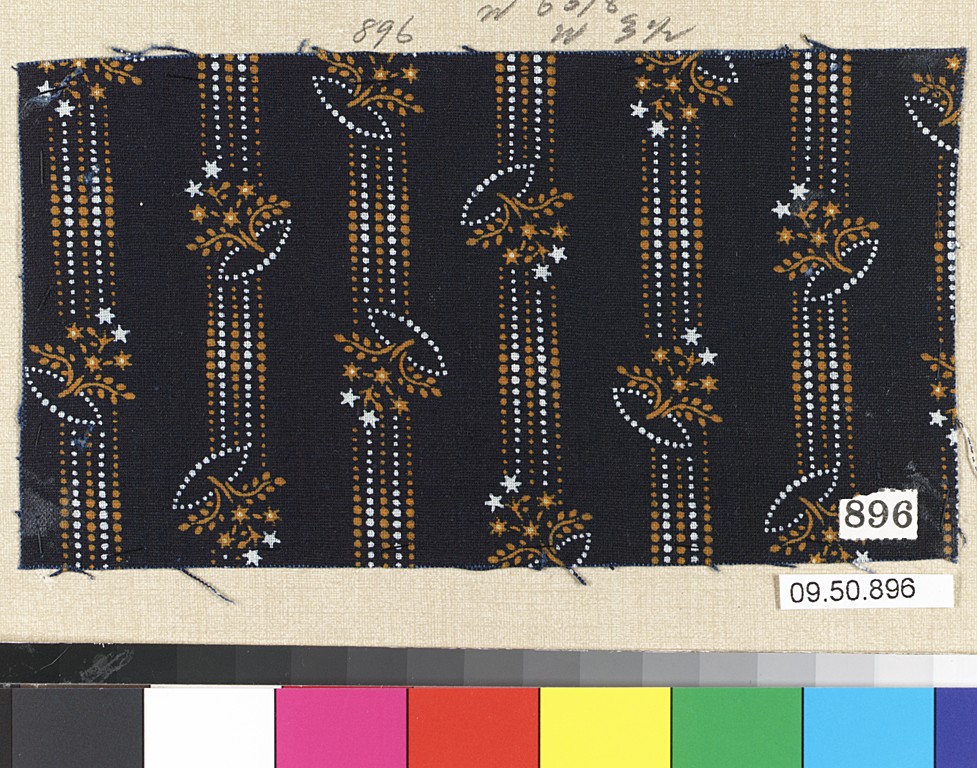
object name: piece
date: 1801-1900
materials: cotton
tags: leaves